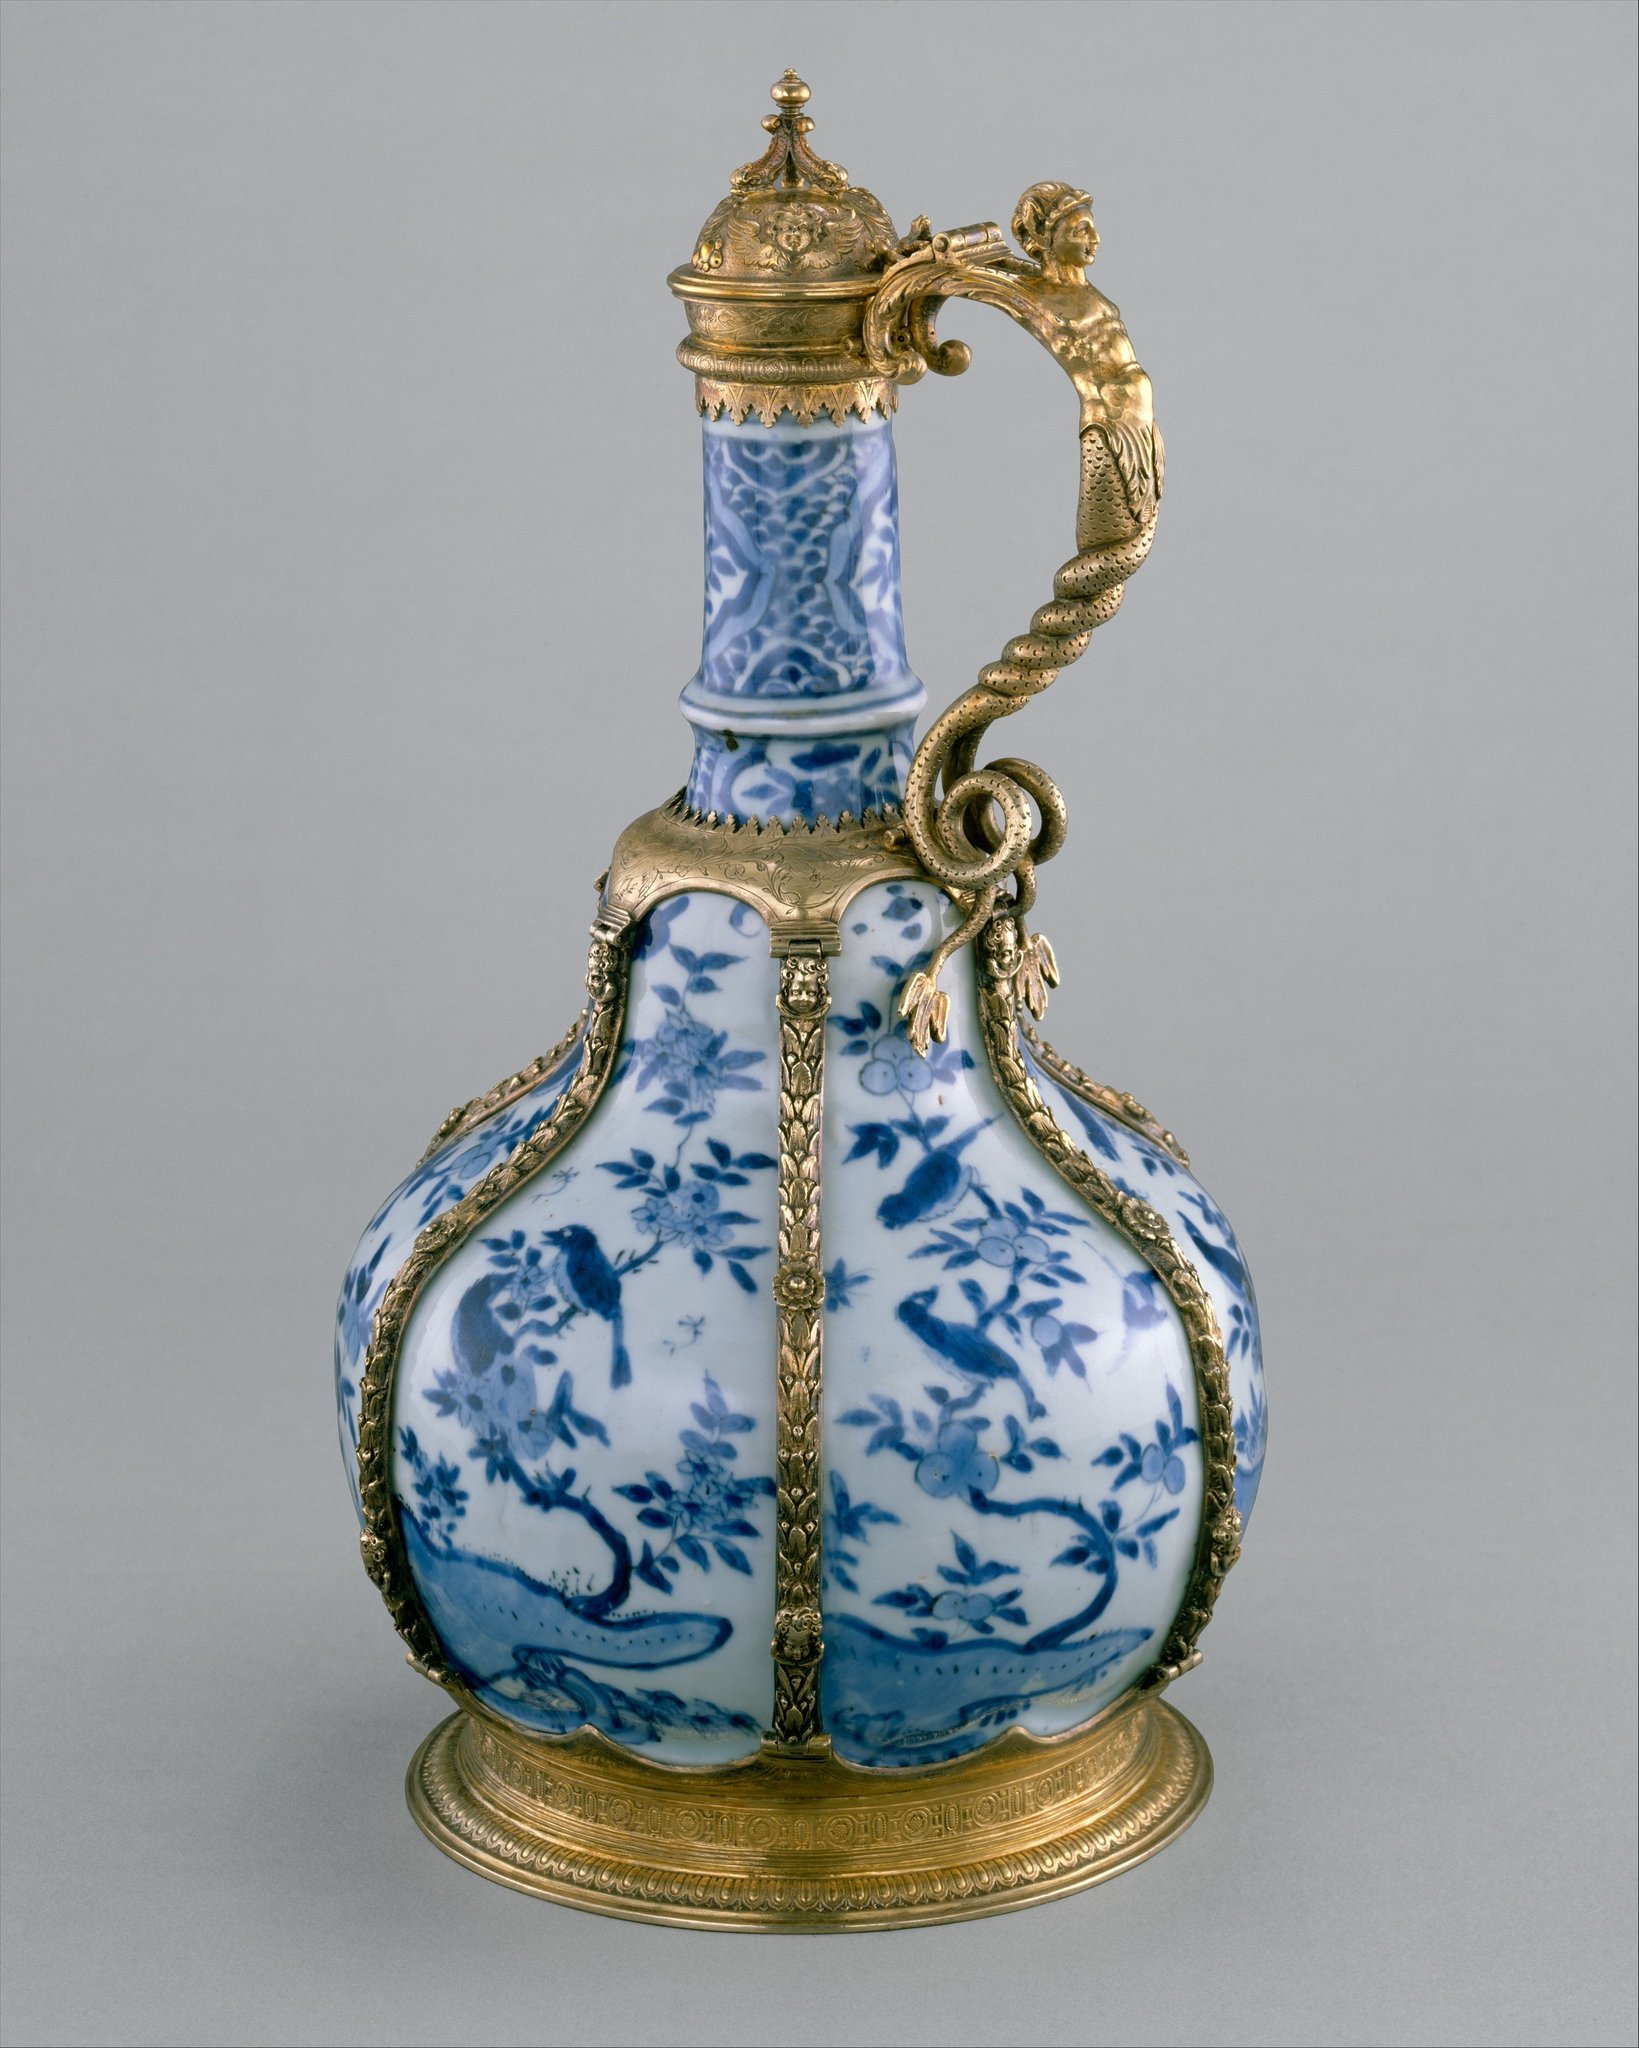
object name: ewer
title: Ewer from Burghley House, Lincolnshire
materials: gilt silver, hard paste porcelain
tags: birds